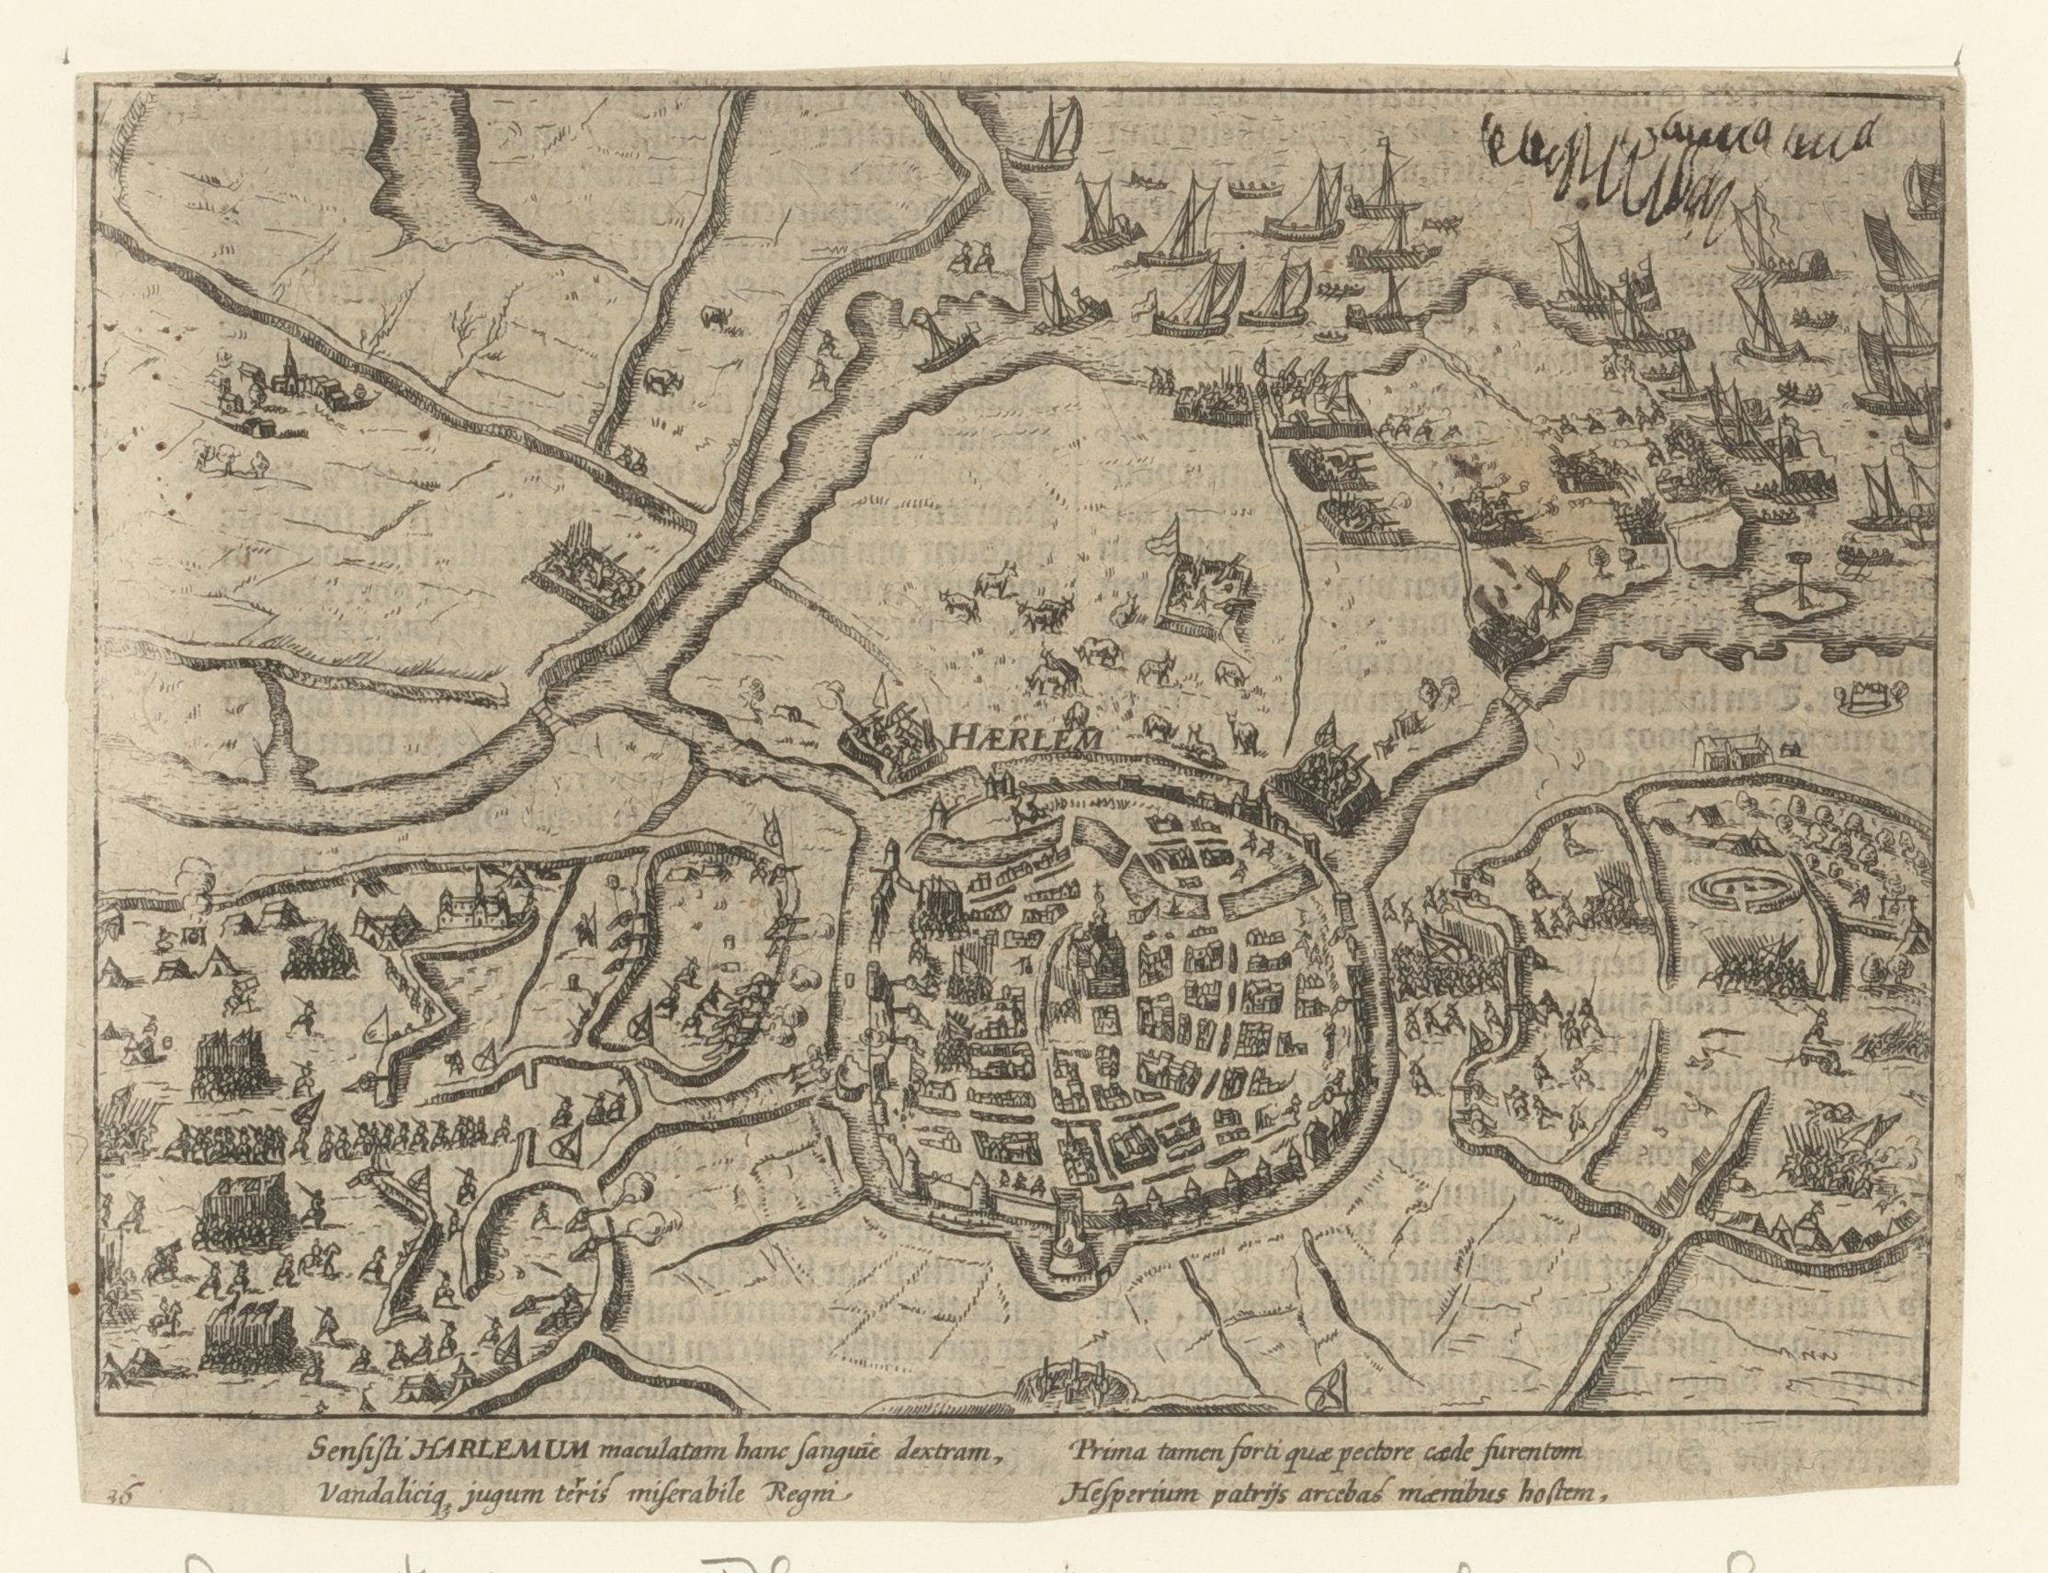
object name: history print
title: Slag op de Zuiderzee, 1573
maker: Anonymous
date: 1613-1615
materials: paper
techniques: etching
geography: northern netherlands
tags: antwerp, earl, politician, battle (+ naval force), enkhuizen, zuiderzee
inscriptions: collector's mark: Lugt 1641, collector's mark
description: De slag op de Zuiderzee, 11 oktober 1573. Zeeslag waarbij de vloot van de watergeuzen onder leiding van Cornelis Dirkszoon van Monnickendam de Spaanse vloot van Bossu verslaat. Links in de verte Enkhuizen. Met onderschrift van 4 regels in het Latijn. Genummerd: 43. Bedrukt op achterzijde met tekst in het Nederlands. Onderwerpsrubrieken binnen de Atlas Zeden en Gewoonten: Krijgswezen; prenten van Baudart. 80j. oorlog.